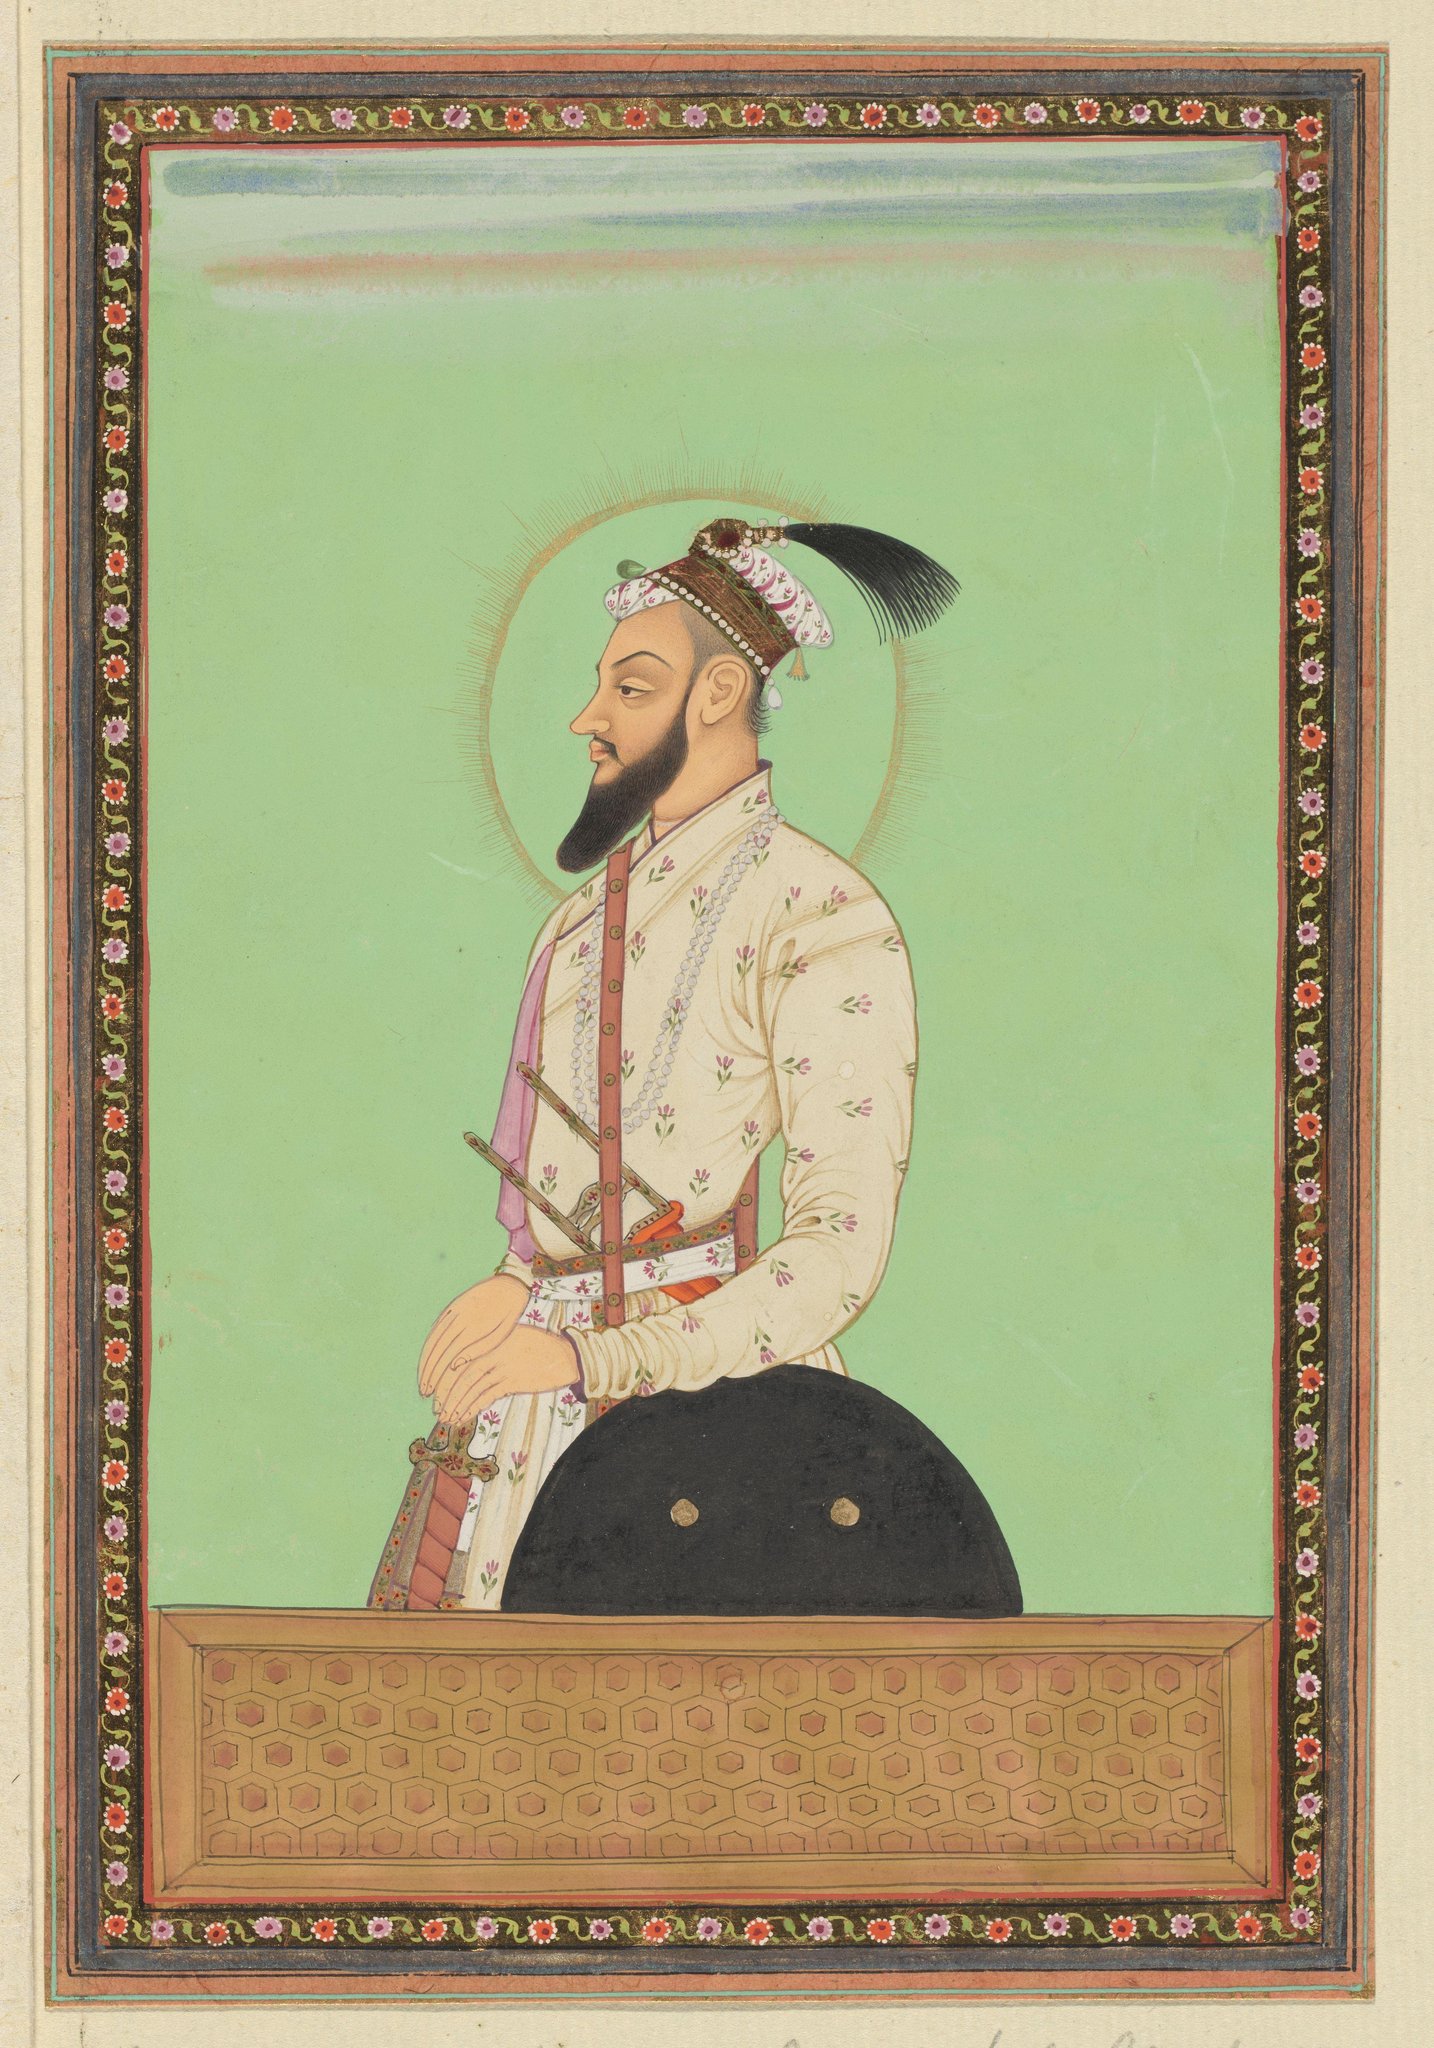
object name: drawing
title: Portret van Shah Alam, zoon van Aurangzeb die na Sultanji werd geboren; hij is eerst gouverneur (subagar) van Deccan geweest; nadat hij vervolgens ten strijde was getrokken tegen Sambaji, de zoon van Sivaji, heeft hij zich nu gekeerd tegen Sultan Abu'l-Hasan en voert oorlog met hem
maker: Anonymous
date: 1686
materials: paint, gold leaf, gouache, paper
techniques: brush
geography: golkonda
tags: amsterdam, mayor, nicolaes cornelisz. witsen, historical person (...) - historical person (...) portrayed alone, ruler, sovereign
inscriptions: collector's mark: Lugt 1838, collector's mark: Lugt 240, annotation: ‘Stah Alem, 2de Zoon van Orangh Seib, Onderkoning van Dajar, of Decan ook genoemd Sultan Mazum, volgt zijn Broeder in het koninkrijk op’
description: Shah Alam is tot aan zijn heupen afgebeeld, naar links gewend, zijn beide handen voor zich op zijn zwaard, in zijn gordel een kattan. Blad 11 in het `Witsen-Album', met 49 Indiase miniaturen van vorsten. Boven het portret een stukje papier met de naam in het Perzisch. Onder het portret een stukje papier met de naam in het Portugees.